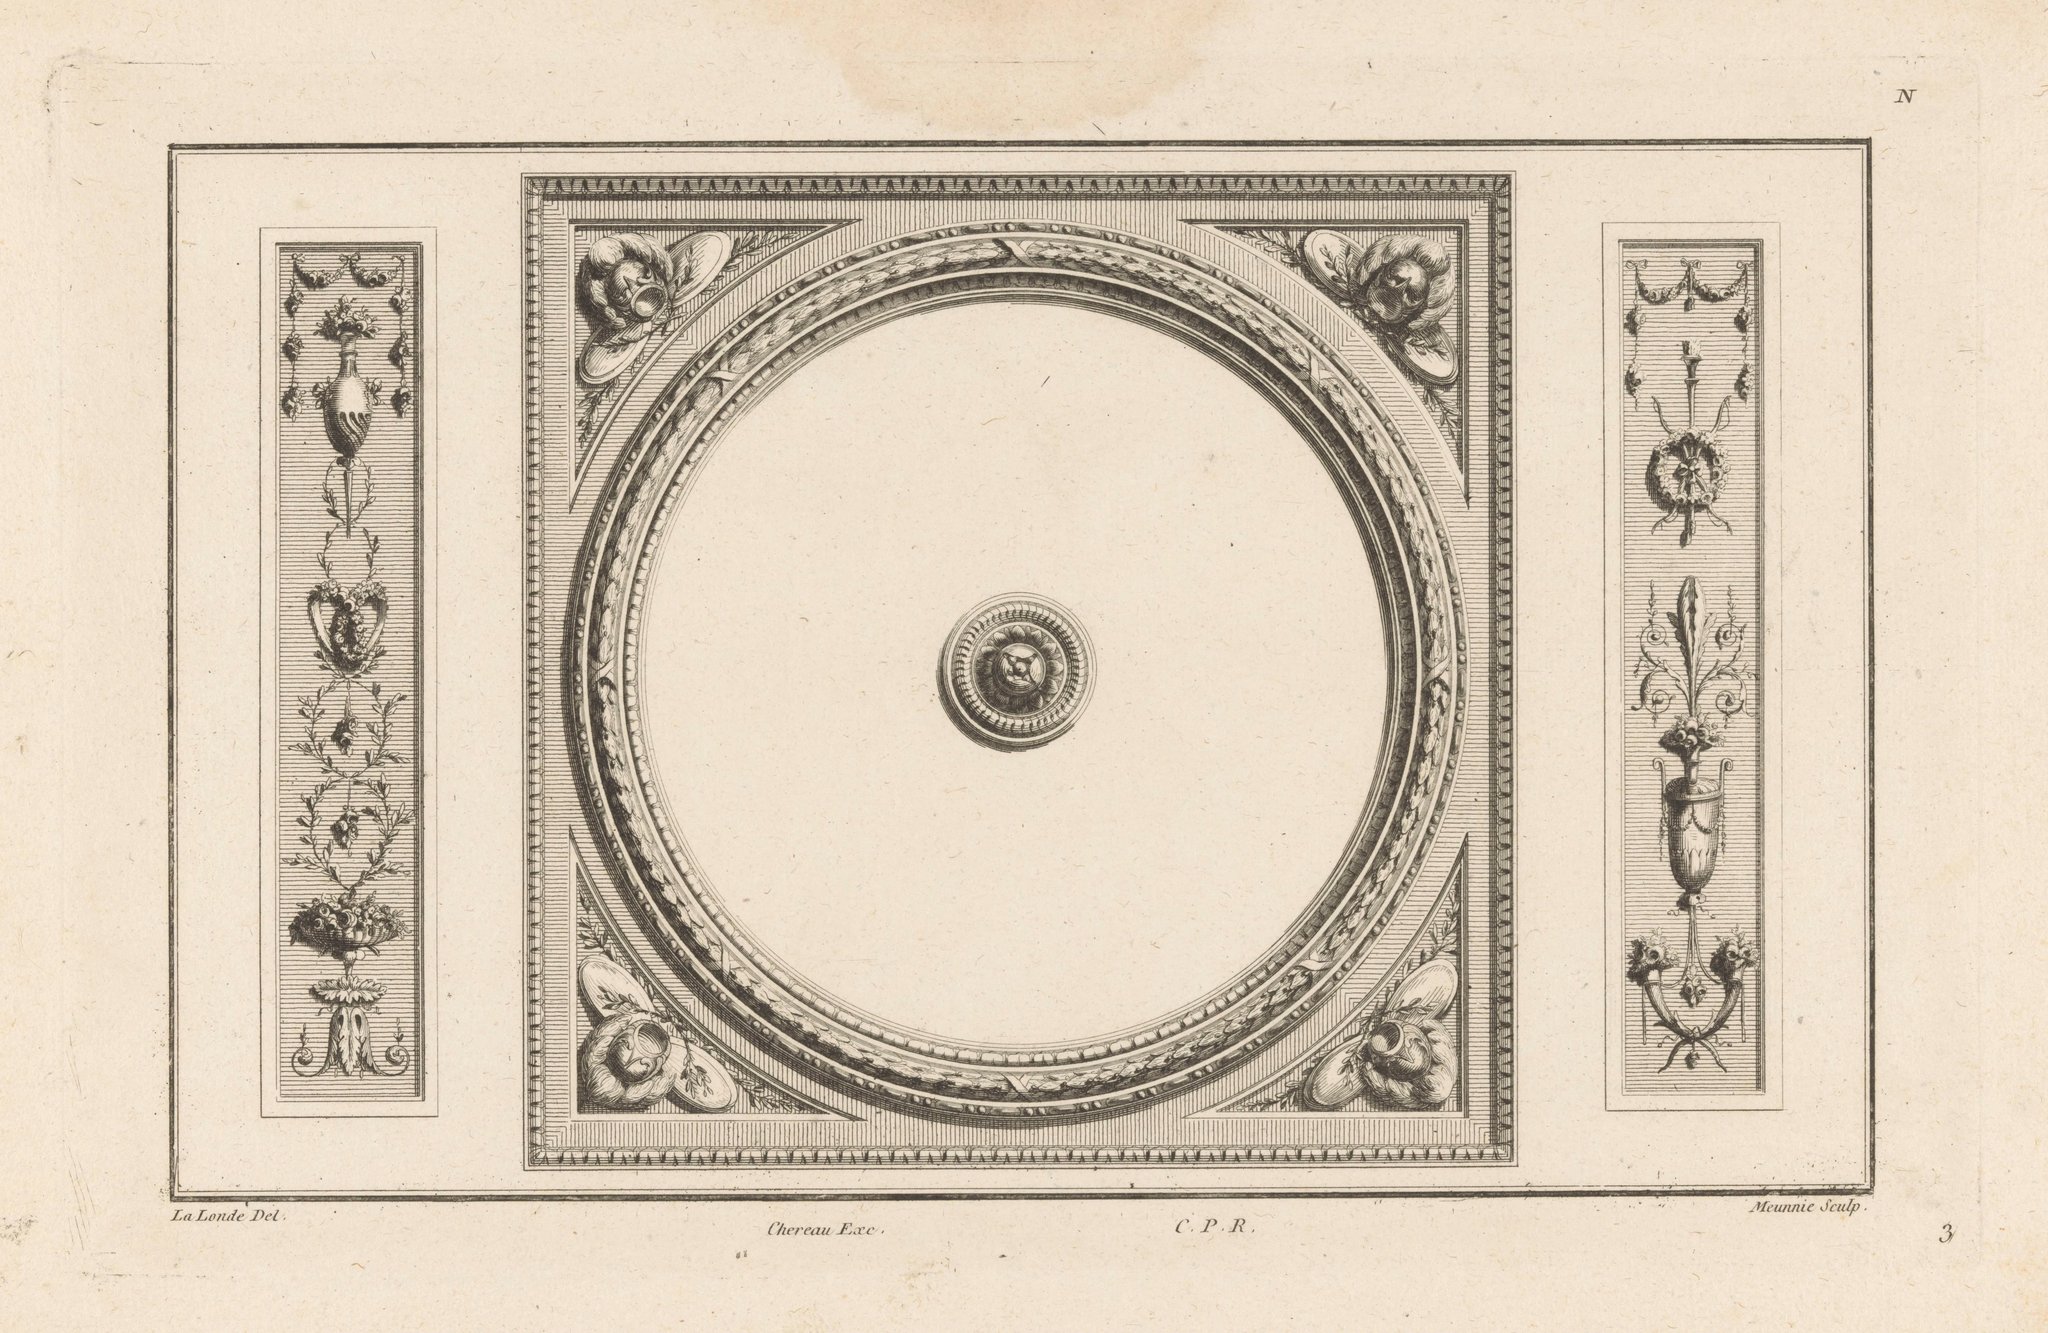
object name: ornament print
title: Plafond met helmen en schilden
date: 1784-1785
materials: paper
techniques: engraving, etching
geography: paris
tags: helmet, protective weapons: shield, (decorated) ceiling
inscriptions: collector's mark: Lugt 2228, collector's mark: Lugt 2760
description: Een rond geornamenteerd plafond met in het midden een rozet. In de vier hoeken pluimenhelmen en schilden. Aan weerszijden van de cirkel panelen met vazen en vlechtwerk.